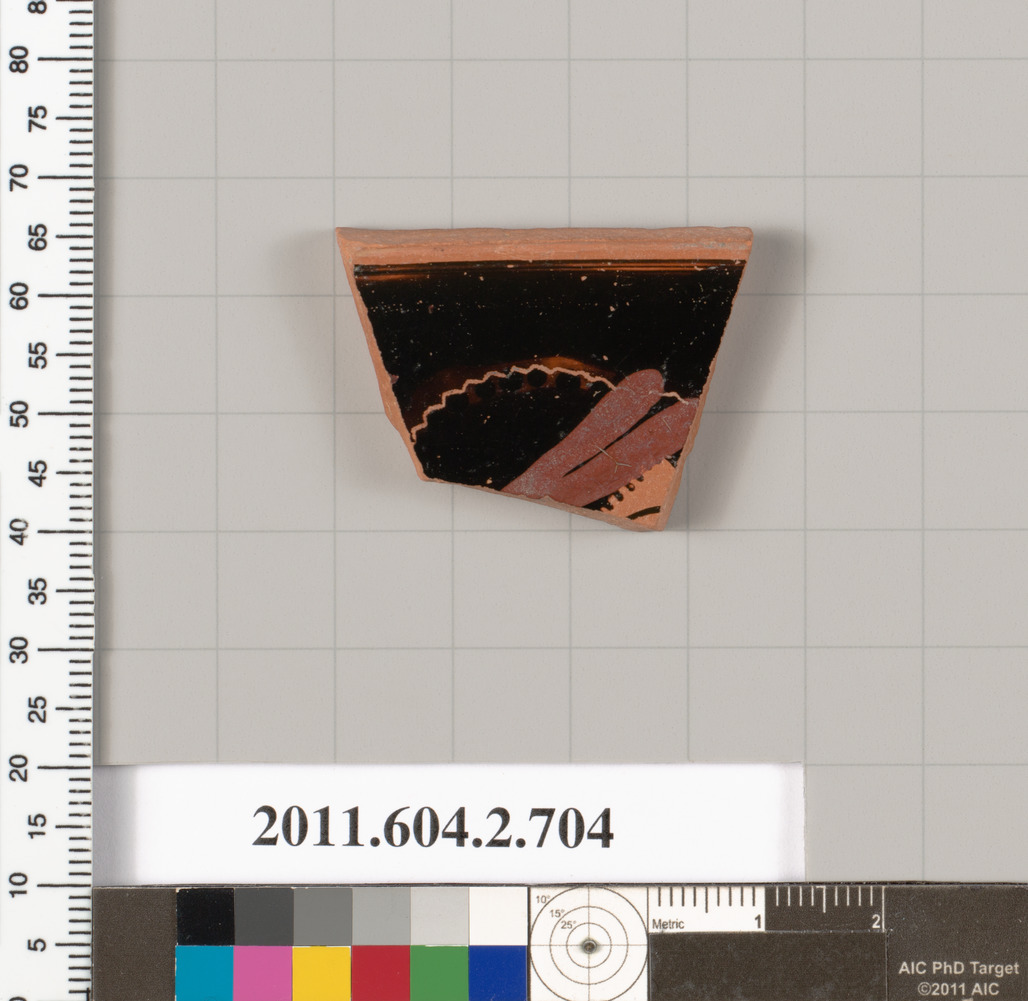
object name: calyx krater fragment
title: Terracotta fragment of a calyx-krater? (bowl for mixing wine and water)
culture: greek, attic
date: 510-500 BCE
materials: terracotta